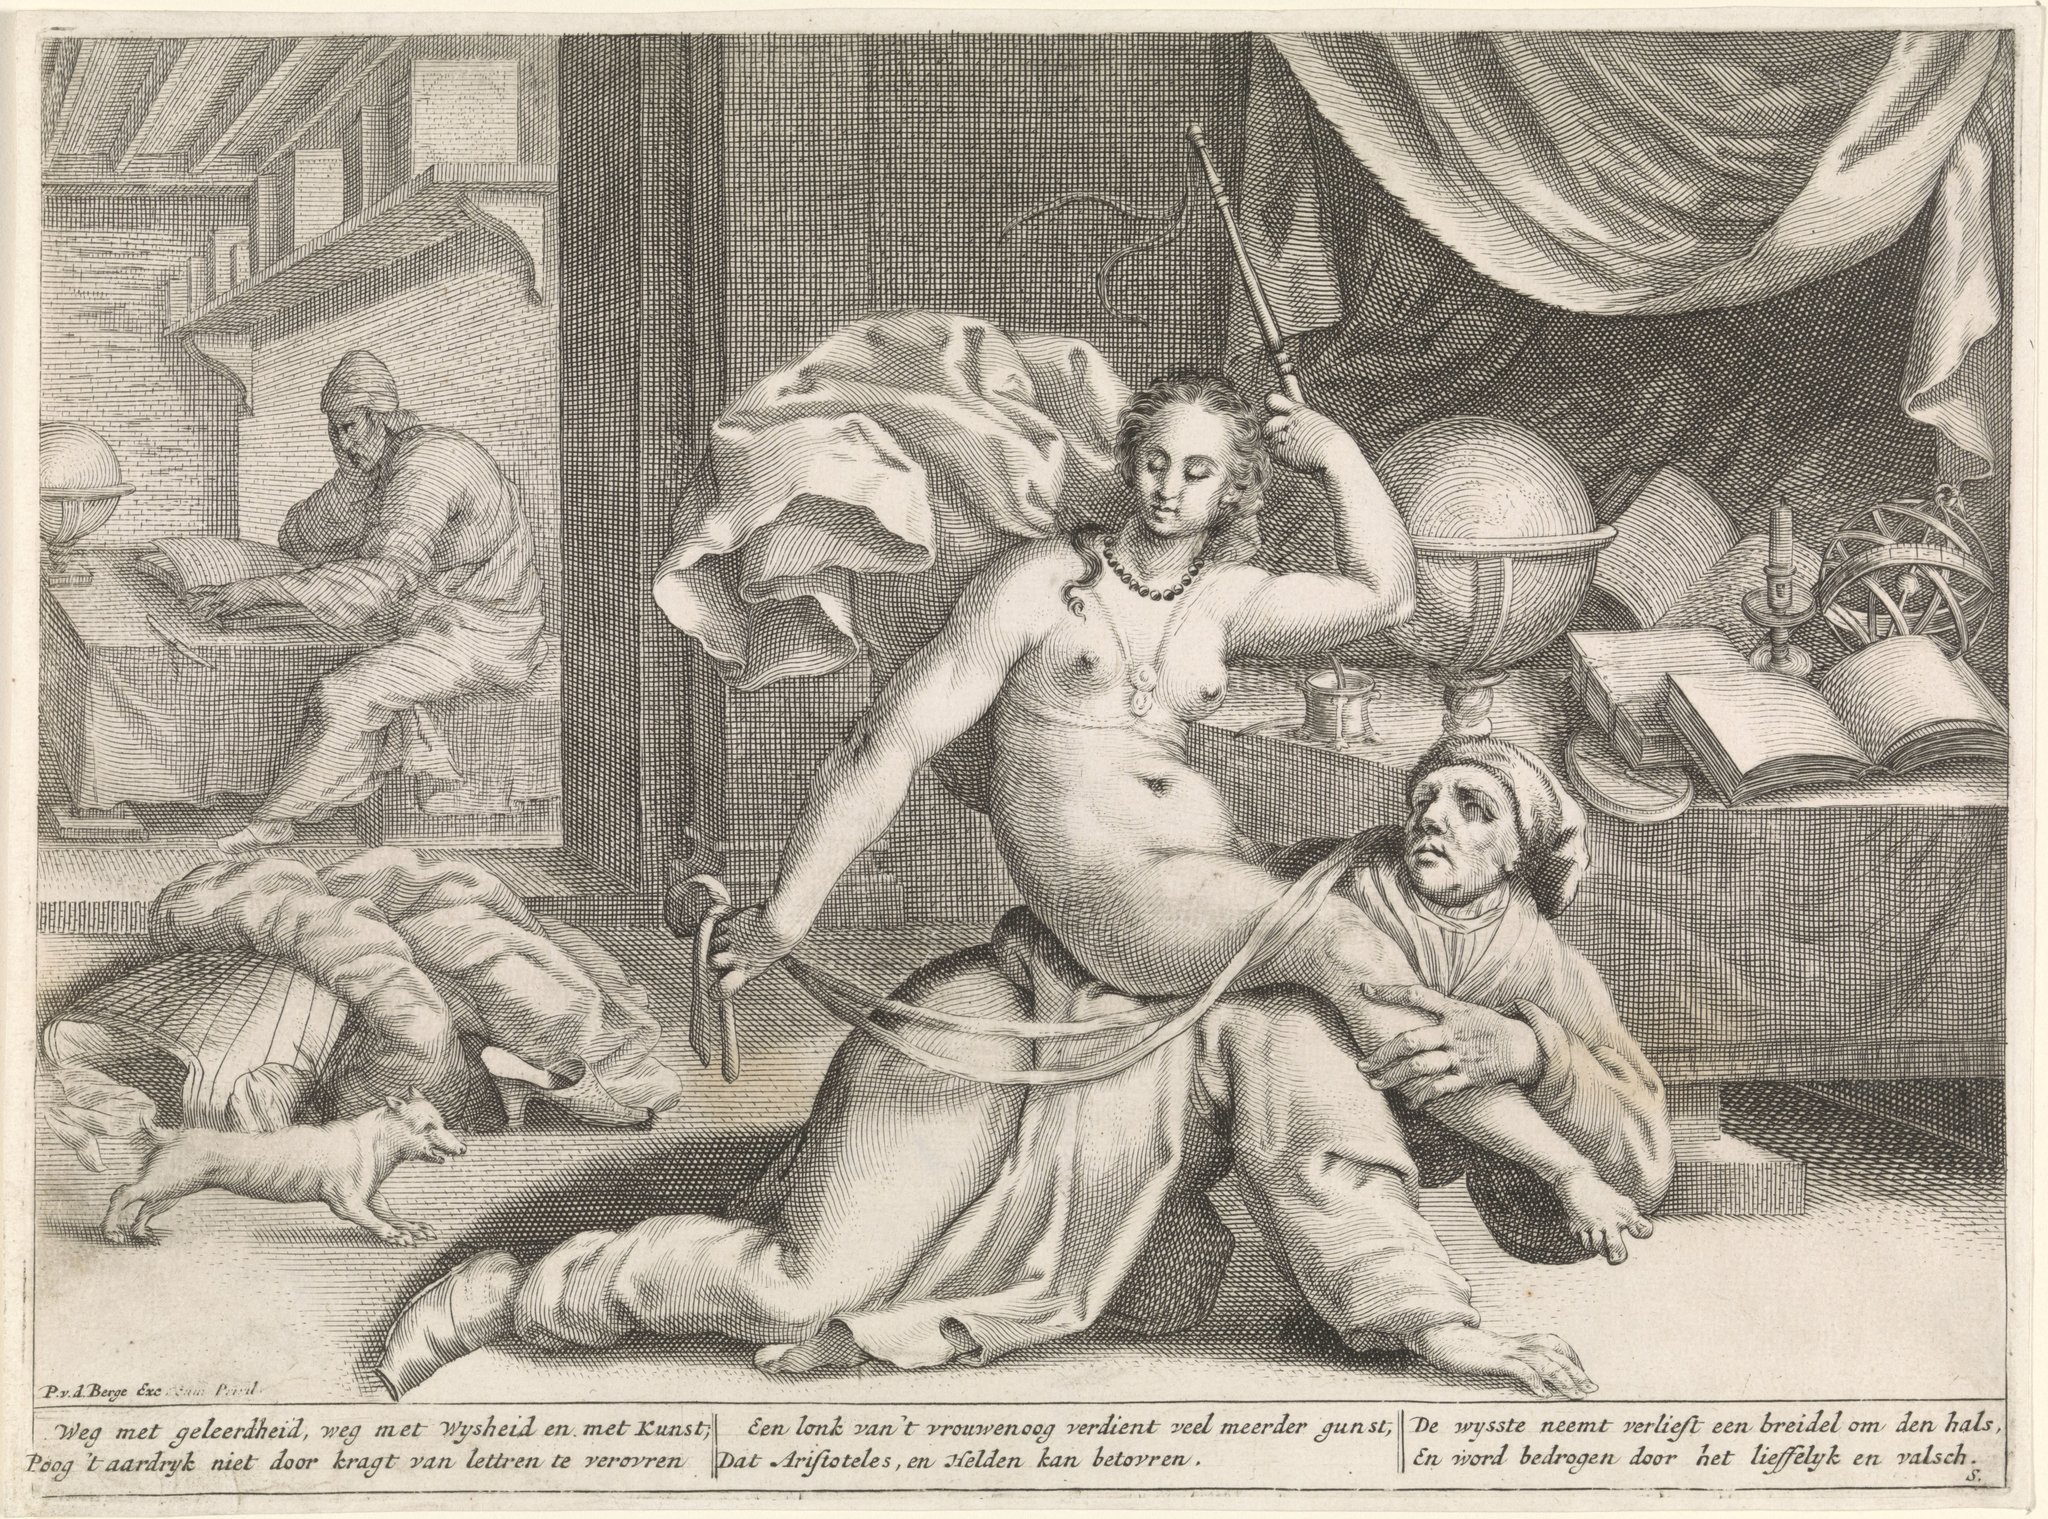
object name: print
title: Aristoteles en Phyllis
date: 1588-1592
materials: paper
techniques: engraving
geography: antwerp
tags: aristotle and phyllis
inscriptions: collector's mark: Lugt 2228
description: Phyllis, van haar kleding ontdaan, berijdt Aristoteles die op handen en voeten rondkruipt in een studeervertrek. Rechts een tafel, waarop een aard- en een hemelglobe, boeken, inktkoker, en een kandelaar. Links op de achtergrond Op de achtergrond Aristoteles als geleerde.